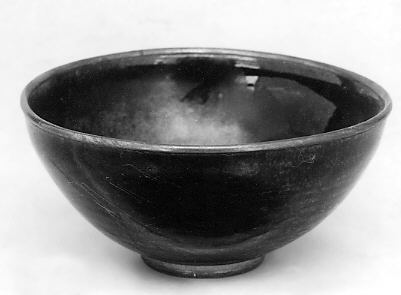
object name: teabowl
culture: japanese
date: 1801-1900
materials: clay, glaze